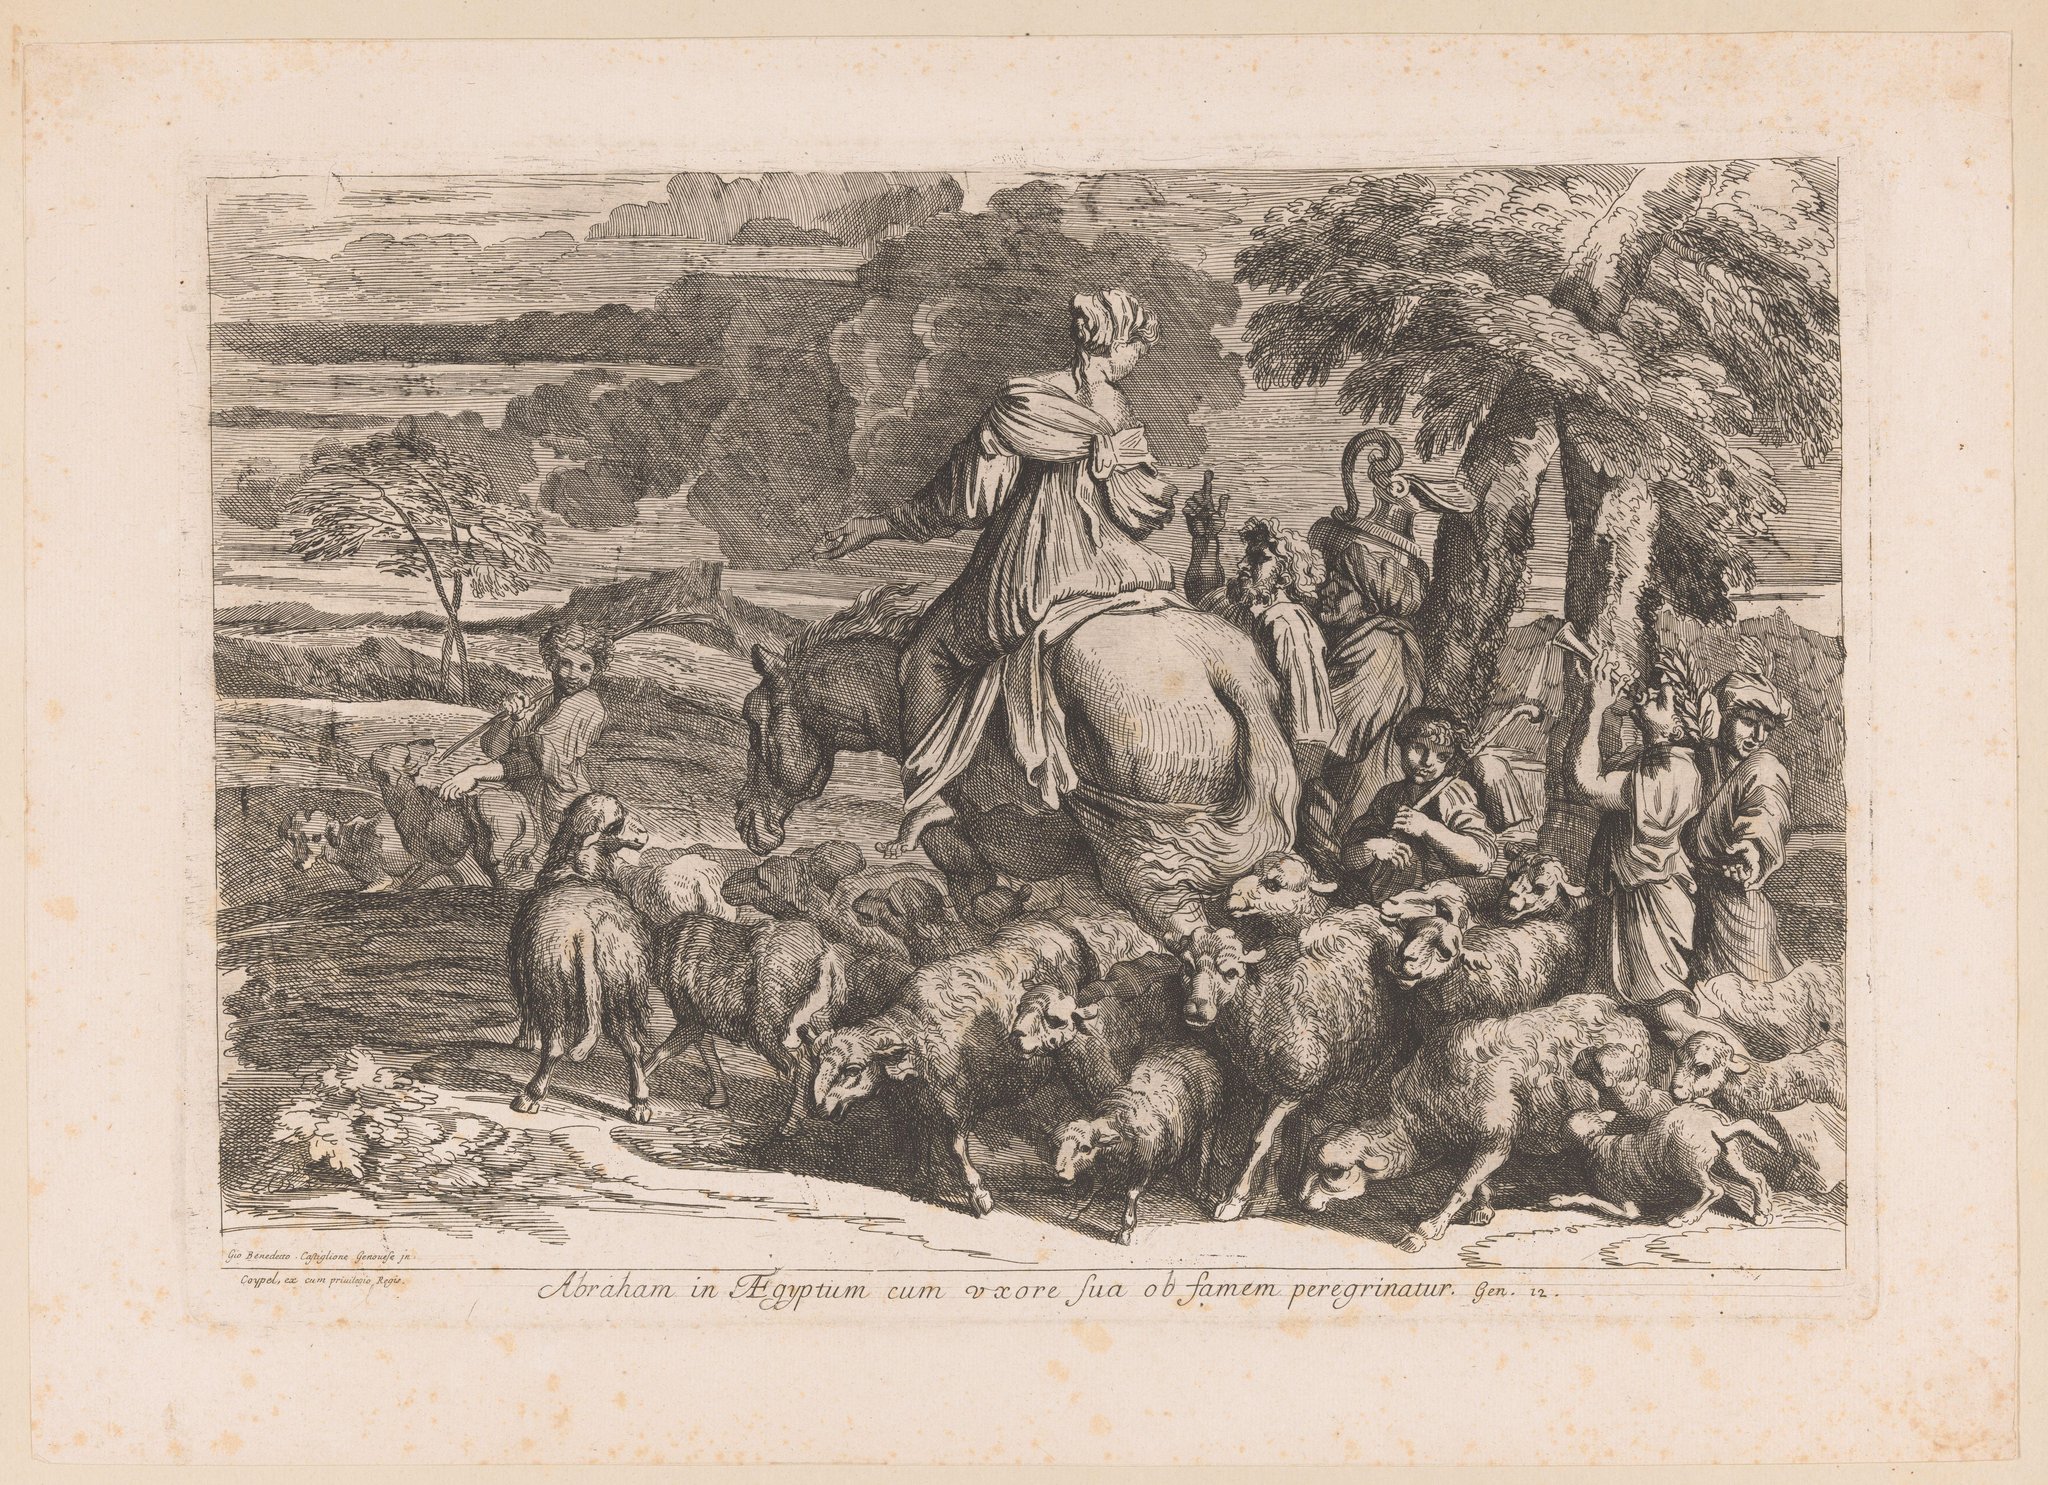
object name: print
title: Abraham op weg naar Egypte met zijn vrouw Sara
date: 1641-1665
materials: paper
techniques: etching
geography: paris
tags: abraham leaves egypt with sarah, lot, and his possessions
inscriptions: collector's mark: Lugt 240